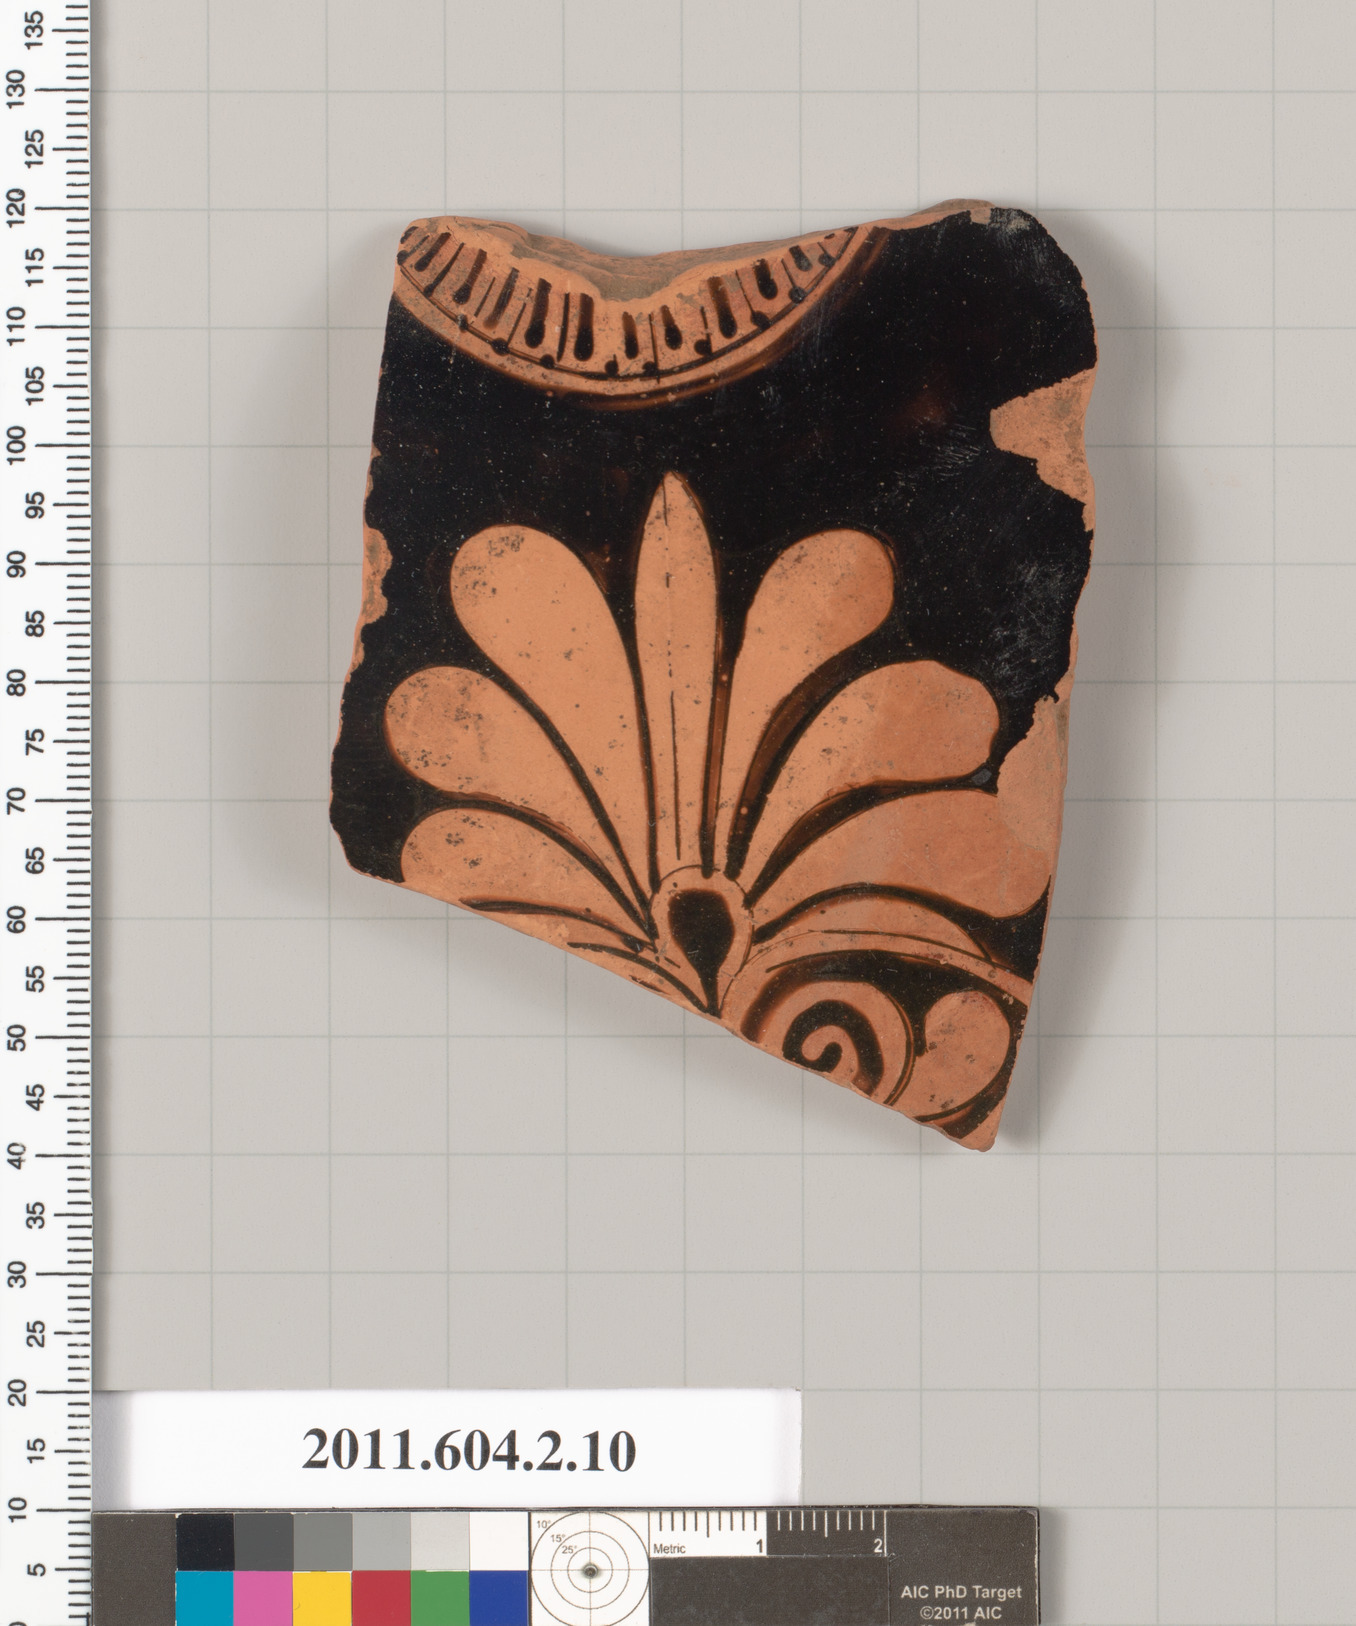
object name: neck amphora fragment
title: Terracotta fragment of a neck-amphora (jar)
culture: greek, attic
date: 460-450 BCE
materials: terracotta